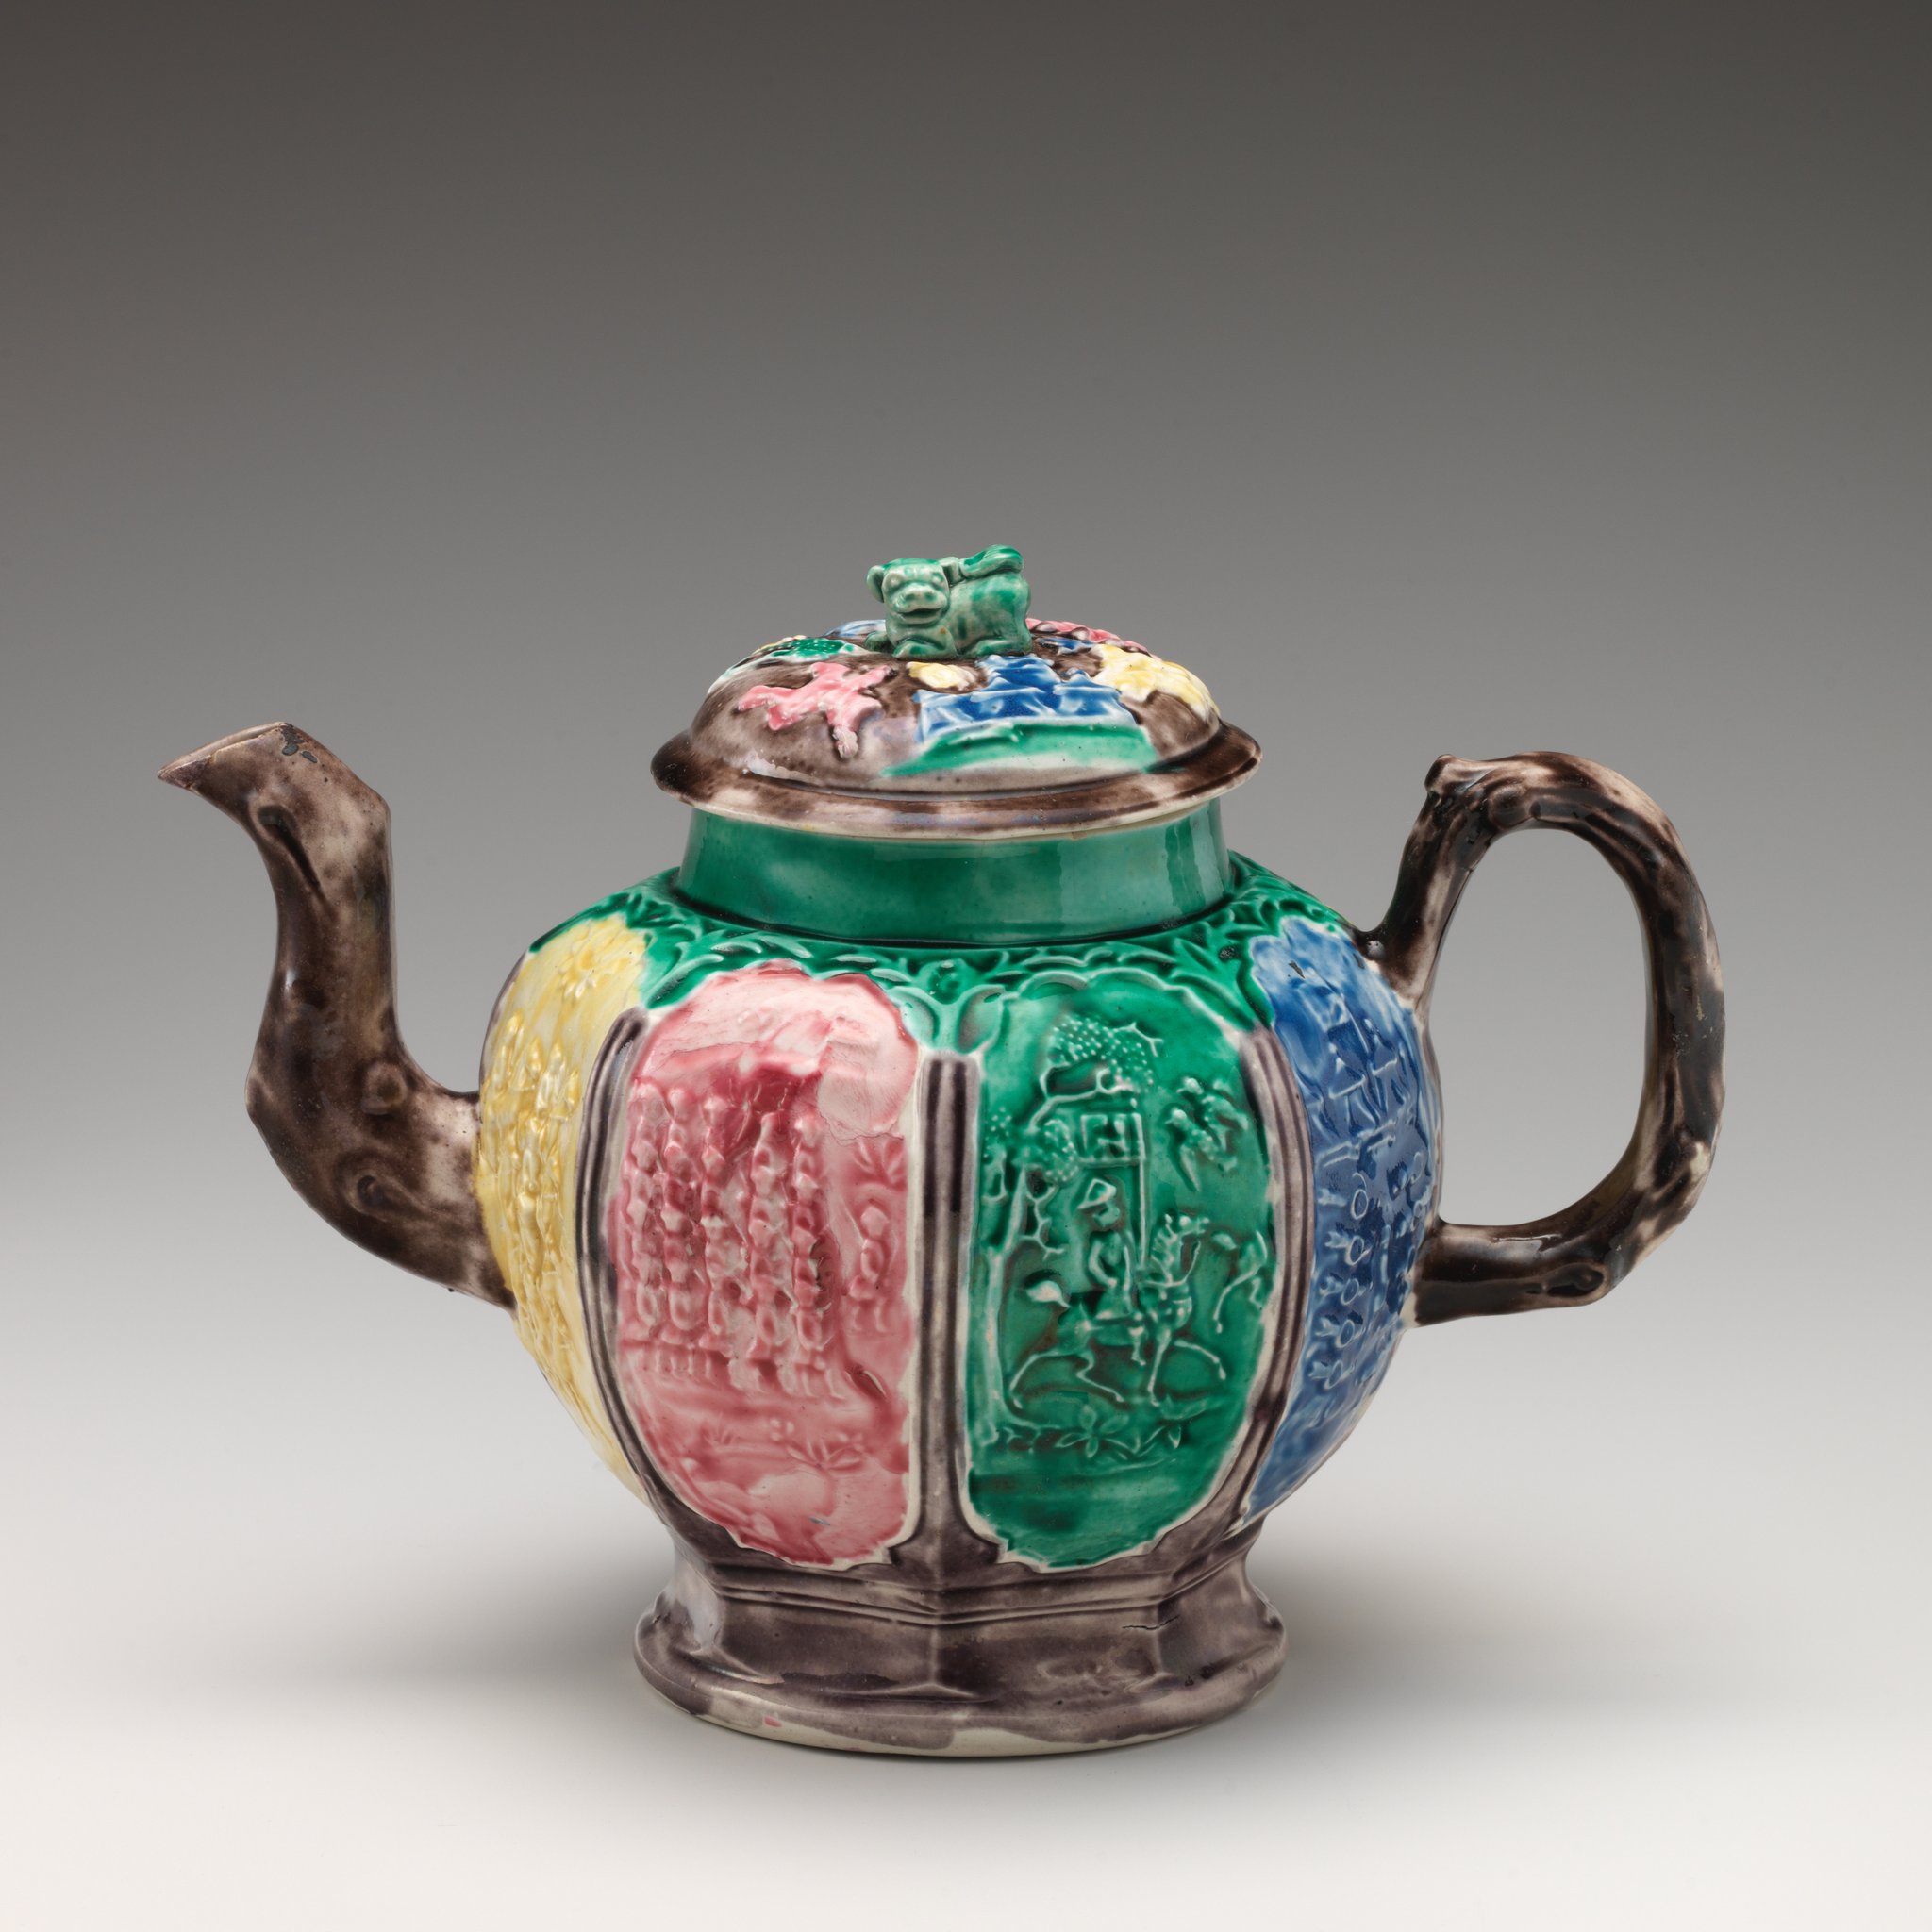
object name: teapot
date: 1750-1755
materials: enamel, stoneware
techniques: salt glaze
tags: human figures,animals,horses